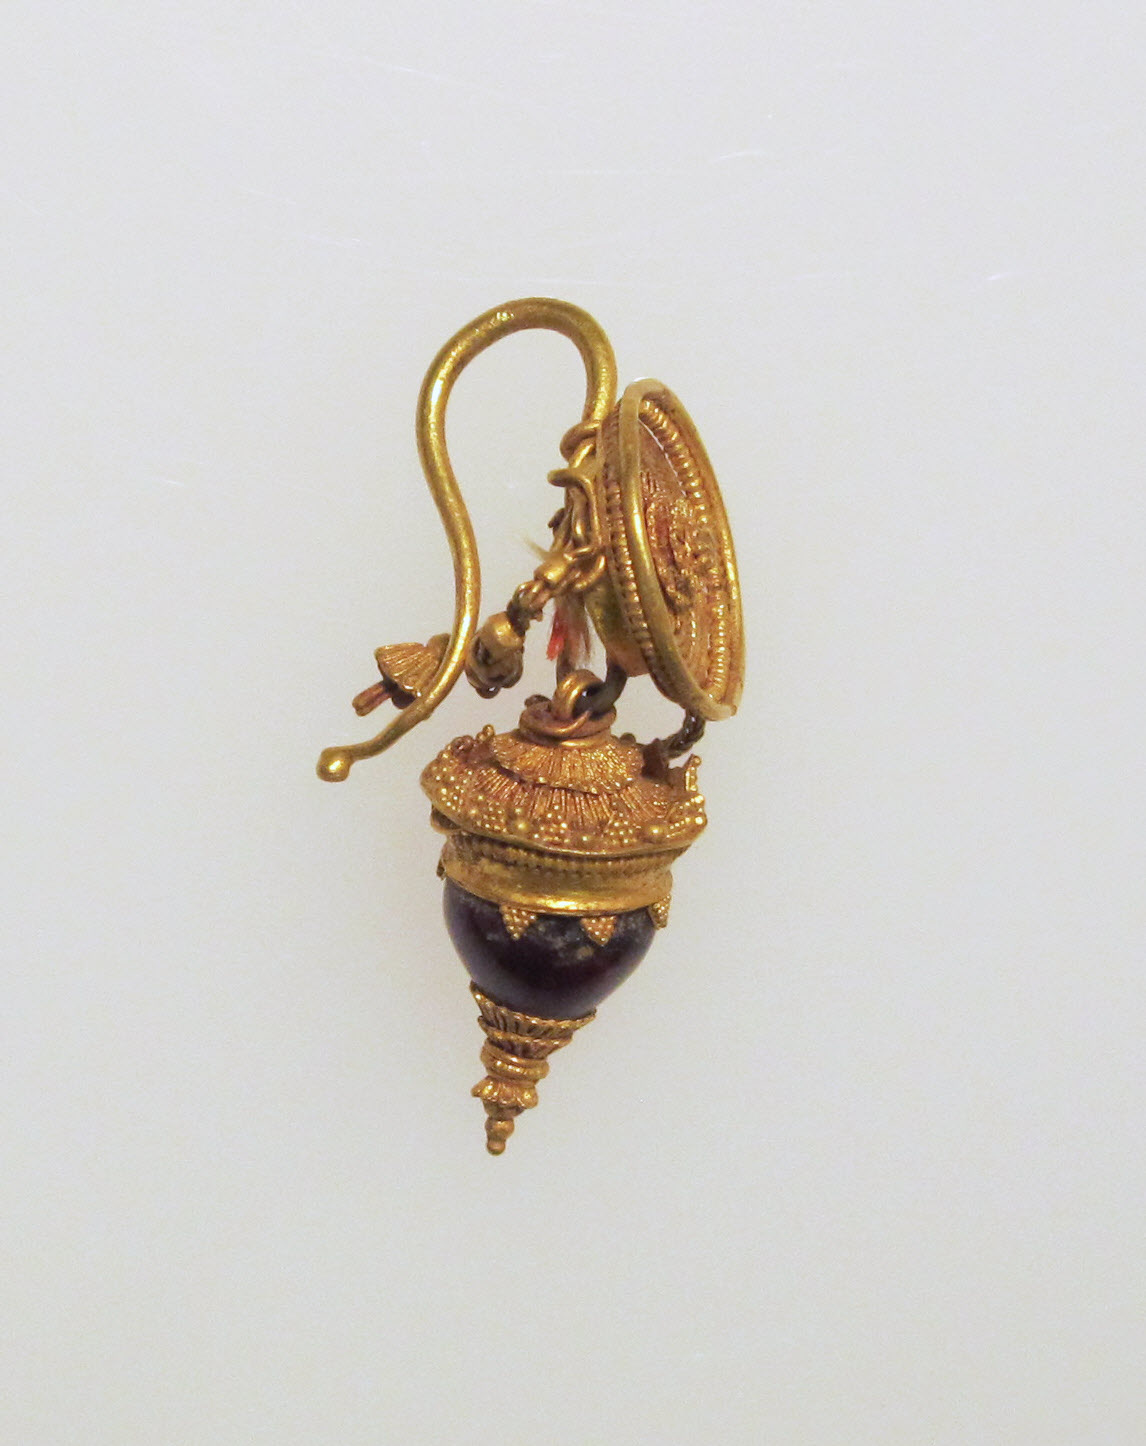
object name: earring with disc, amphora, chain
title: Earring with disc, amphora, chains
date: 7000 BCE-330 CE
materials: gemstone, gold